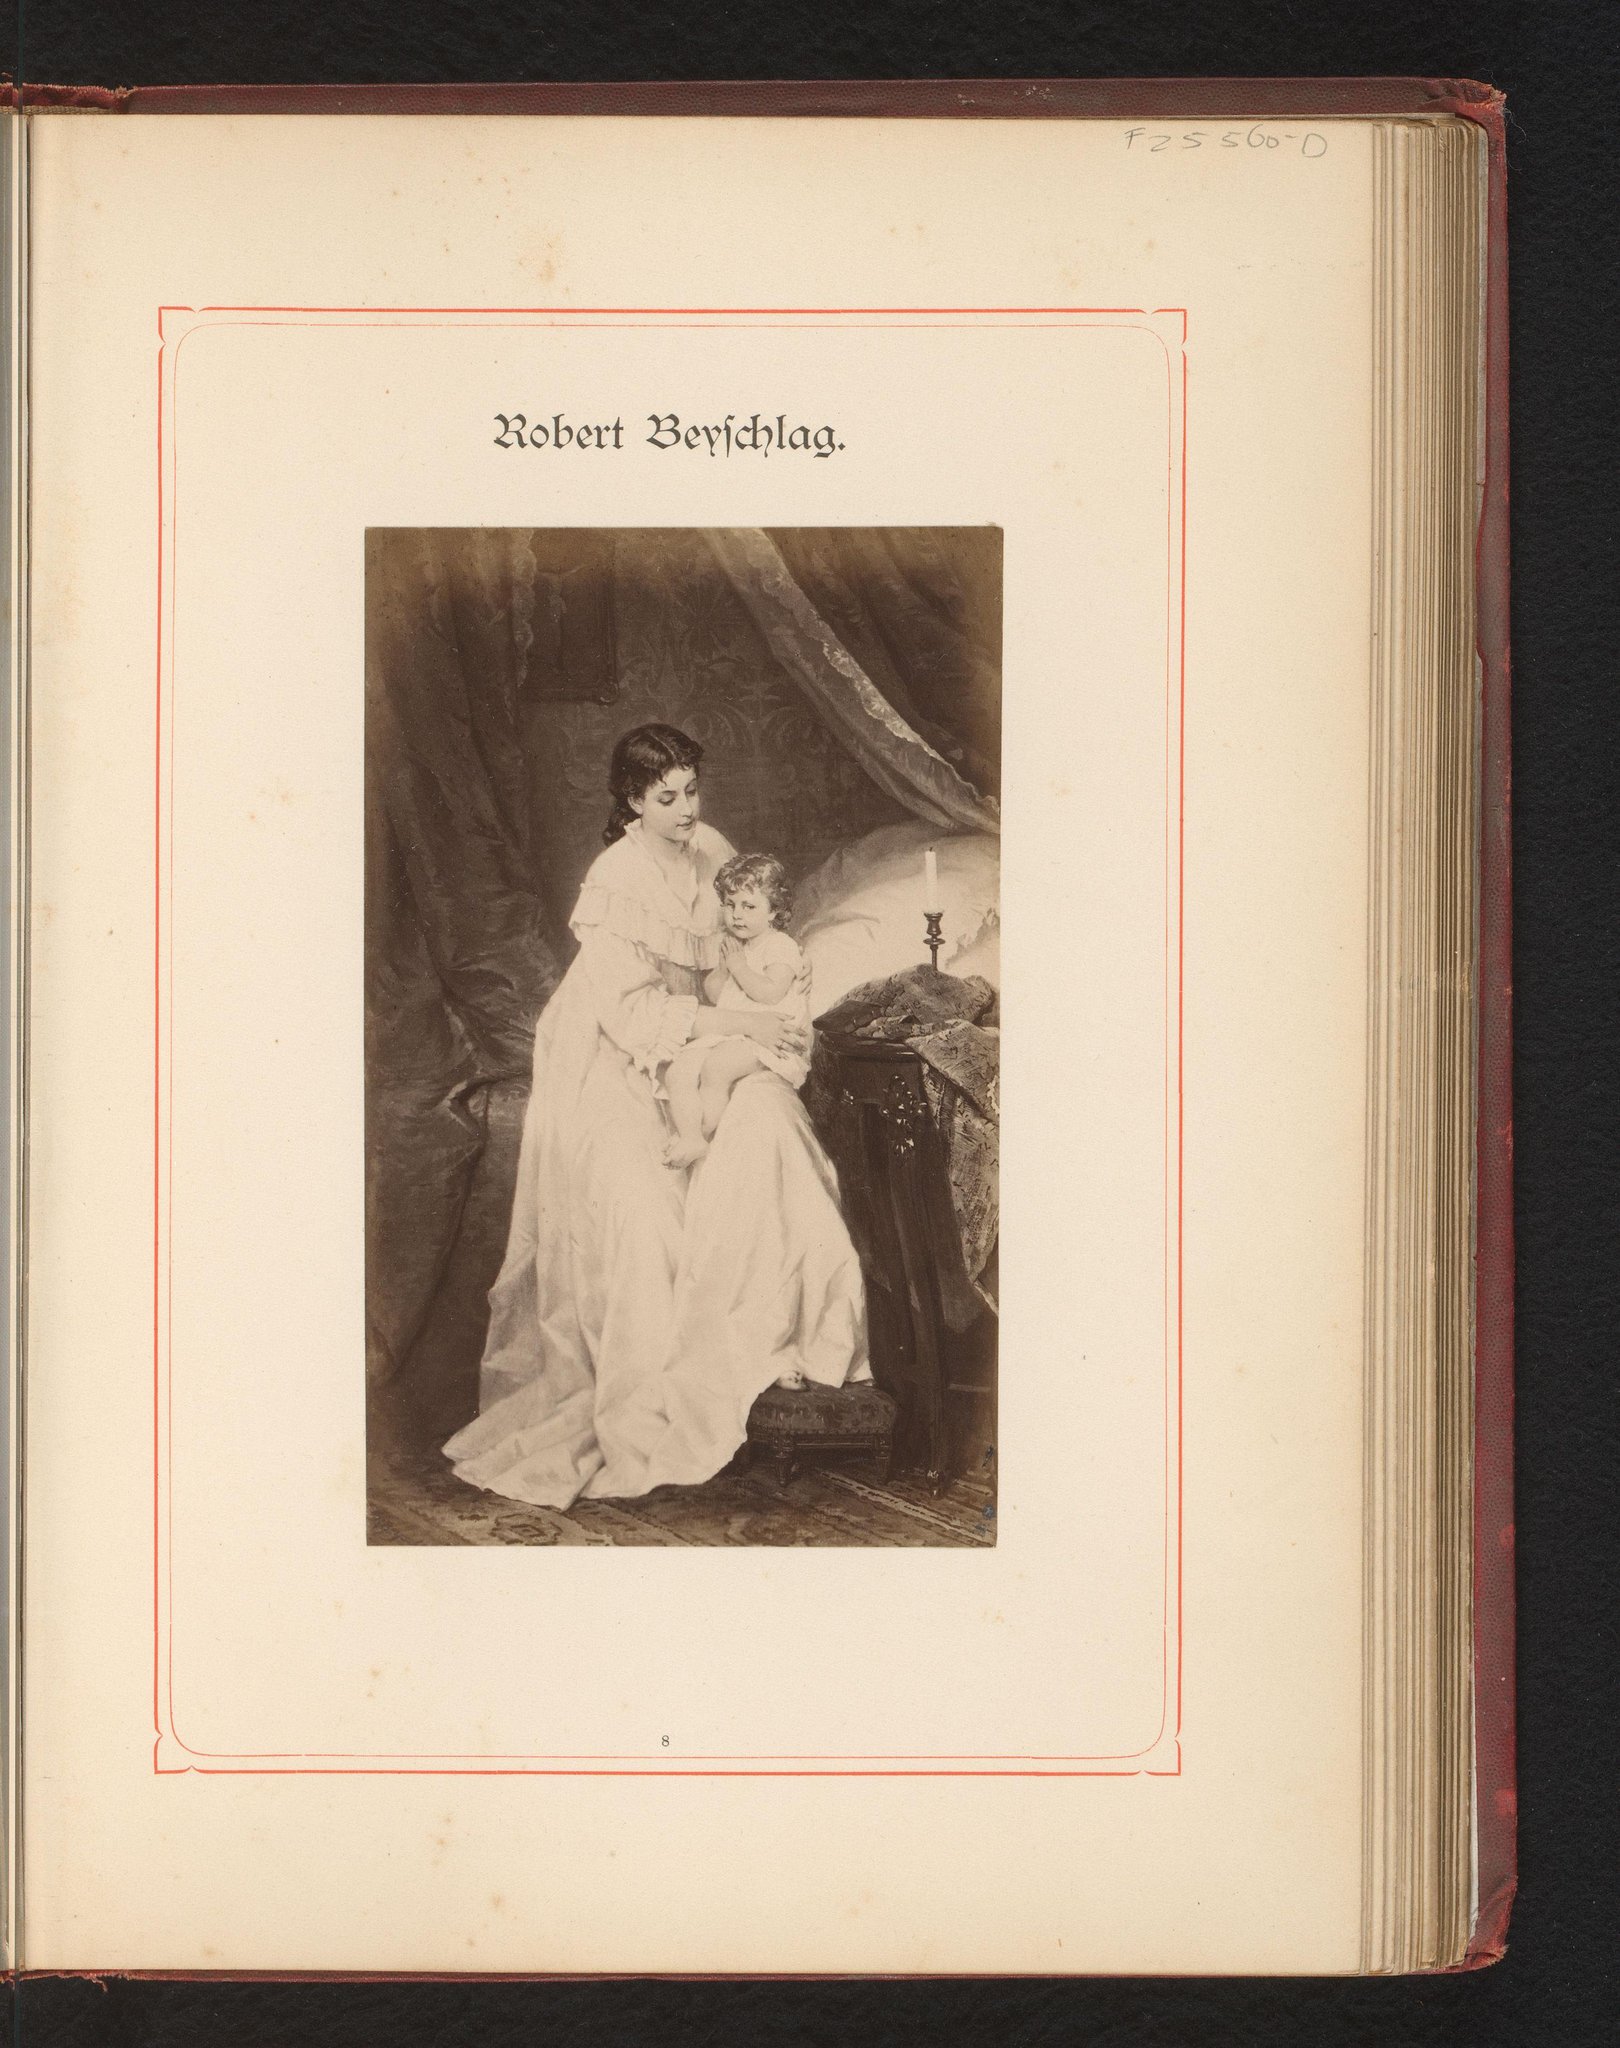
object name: reproduction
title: Fotoreproductie van een schilderij van een vrouw met kind door Robert Beyschlag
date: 1870-1890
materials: paper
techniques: albumen print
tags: bed, picture, painting